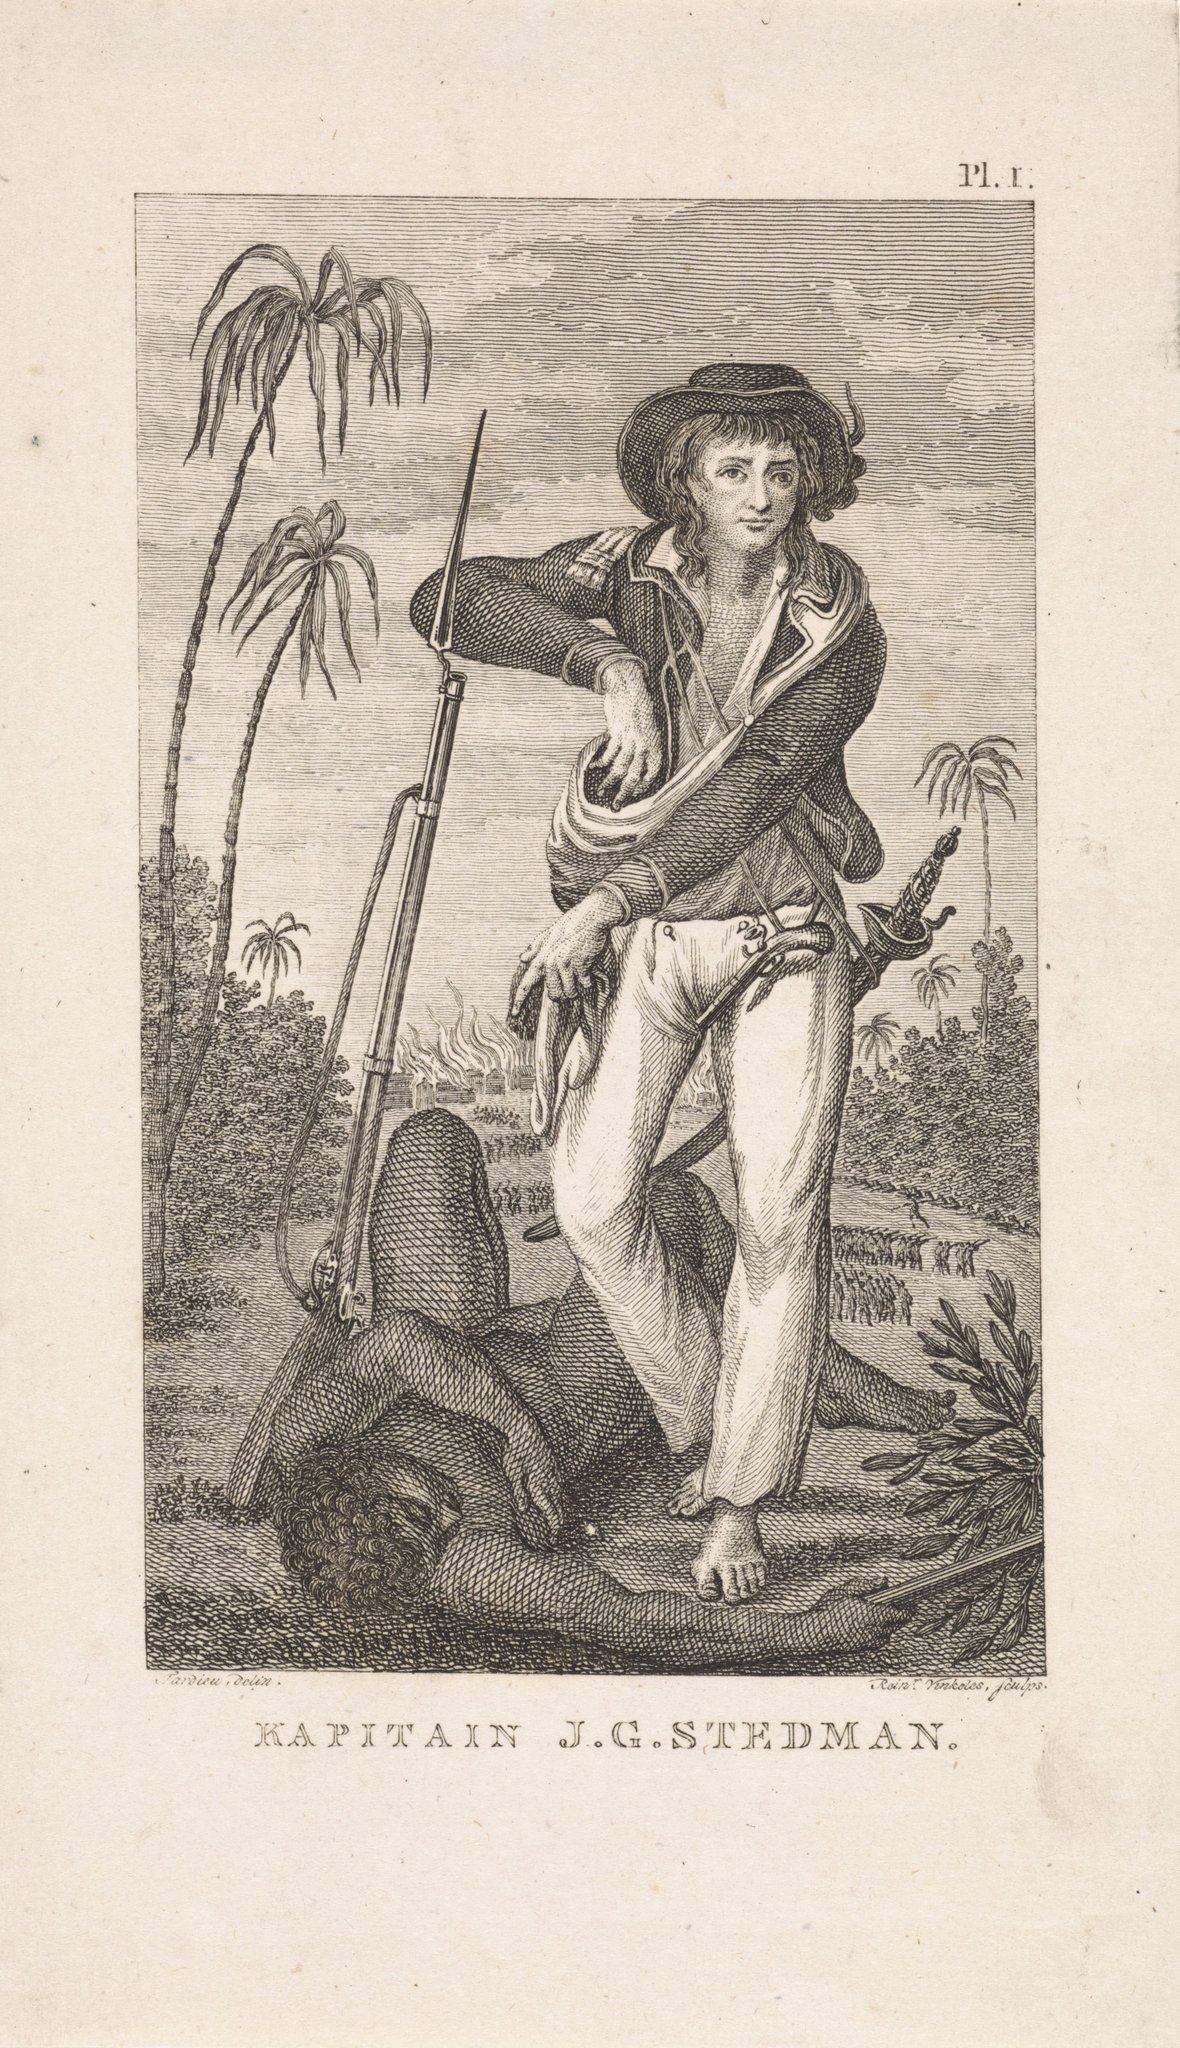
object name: print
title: Portret van John Gabriël Stedman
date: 1751-1816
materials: paper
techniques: engraving, etching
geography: amsterdam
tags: john gabriël stedman, indigenous peoples of south america, firearms: rifle, burning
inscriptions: collector's mark: Lugt 2228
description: Portret van John Gabriël Stedman. Naast hem op de grond een gewonde zwarte man. Op de achtergrond een brandend dorp. Rechtsboven: Pl. I.